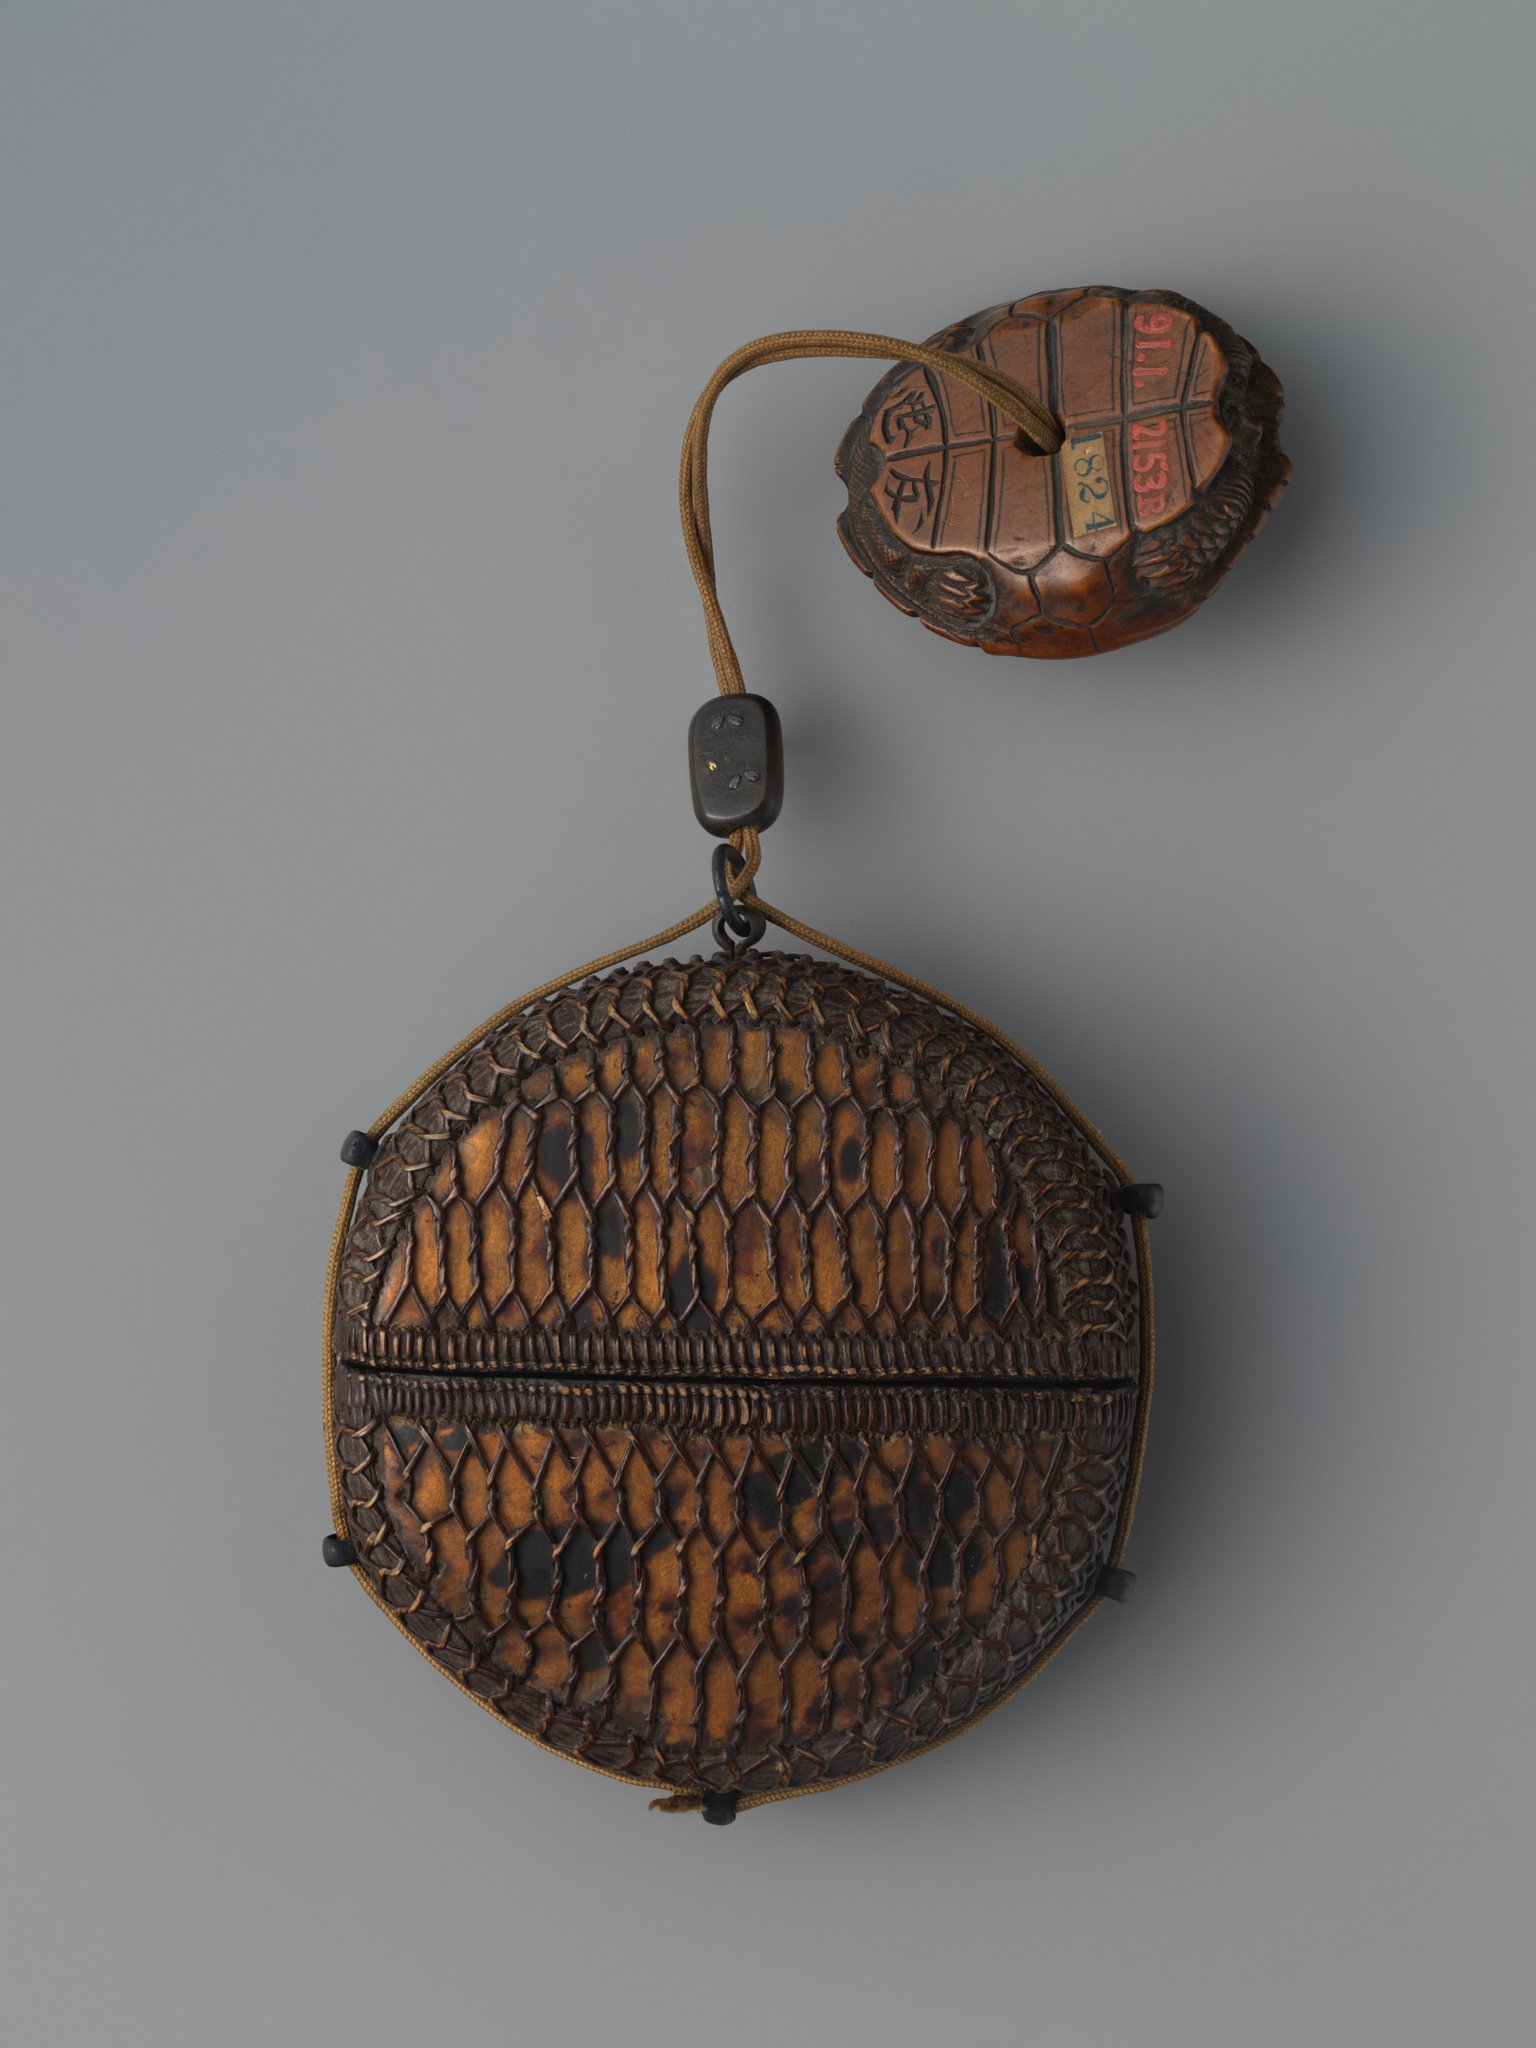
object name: inrō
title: Tortoiseshell and Basketry Inrō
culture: japanese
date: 1601-1700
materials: copper, lacquer, metal, rattan, shell, wood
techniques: carving, inlay, urushi